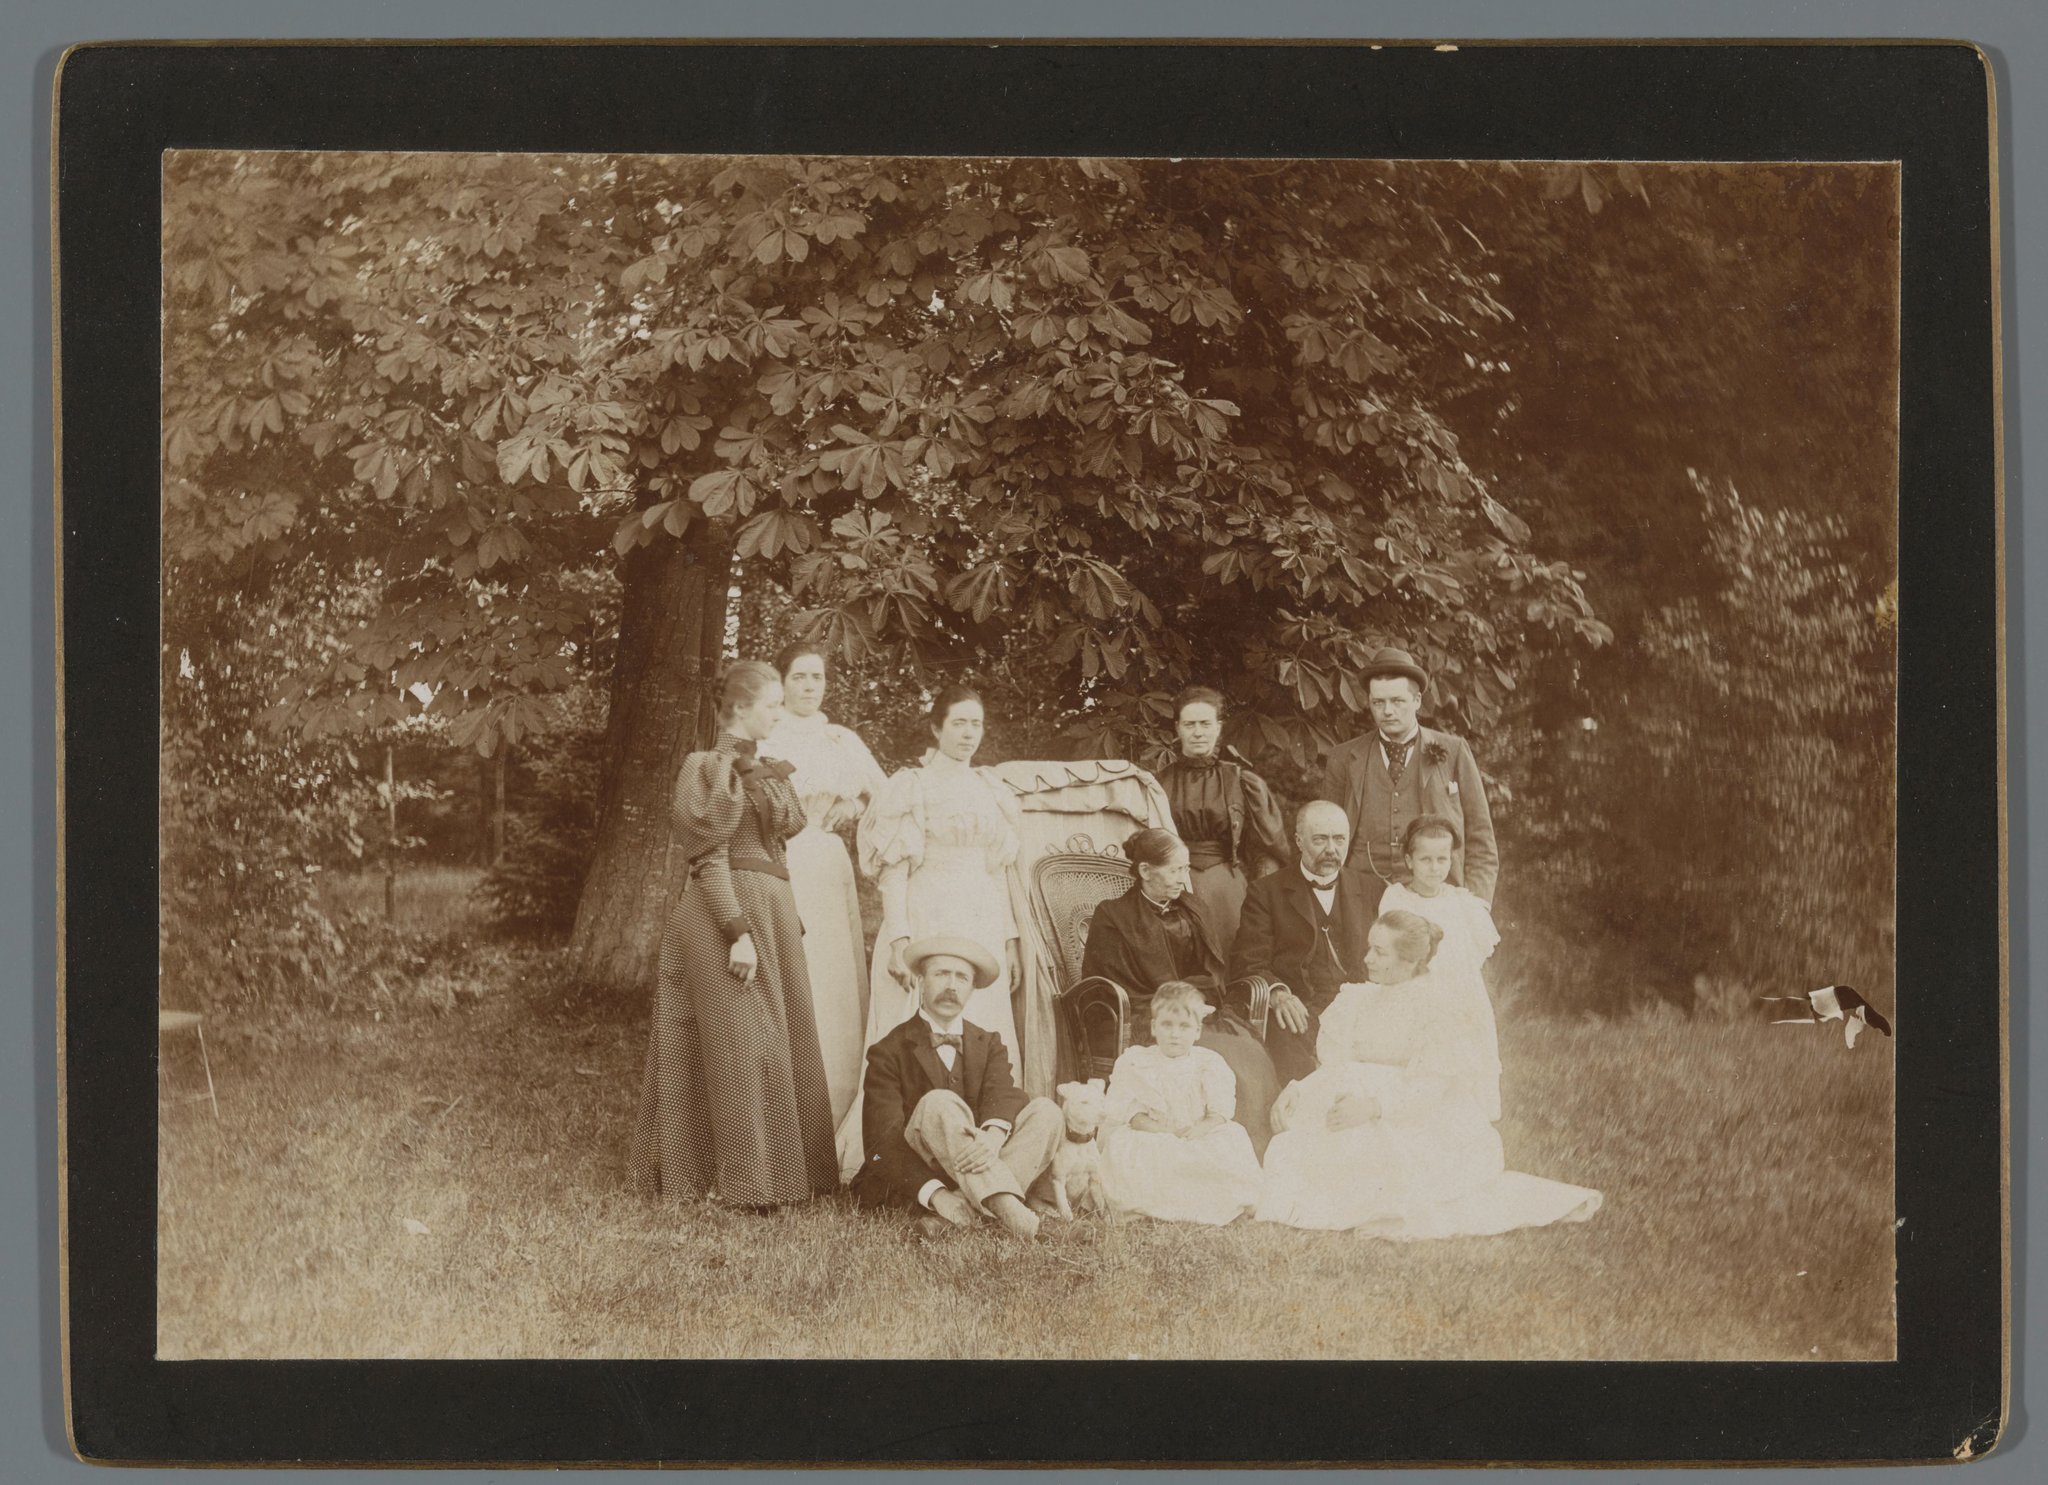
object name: photograph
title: Groepsportret van familie Jonker en Jonker Nije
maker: cornelia hendrika jonker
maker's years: 1874-1924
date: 1896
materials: cardboard, photographic support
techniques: collodion silver print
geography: maartensdijk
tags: cornelia hendrika jonker, garden, anonymous historical persons portrayed in a group, in a group-portrait